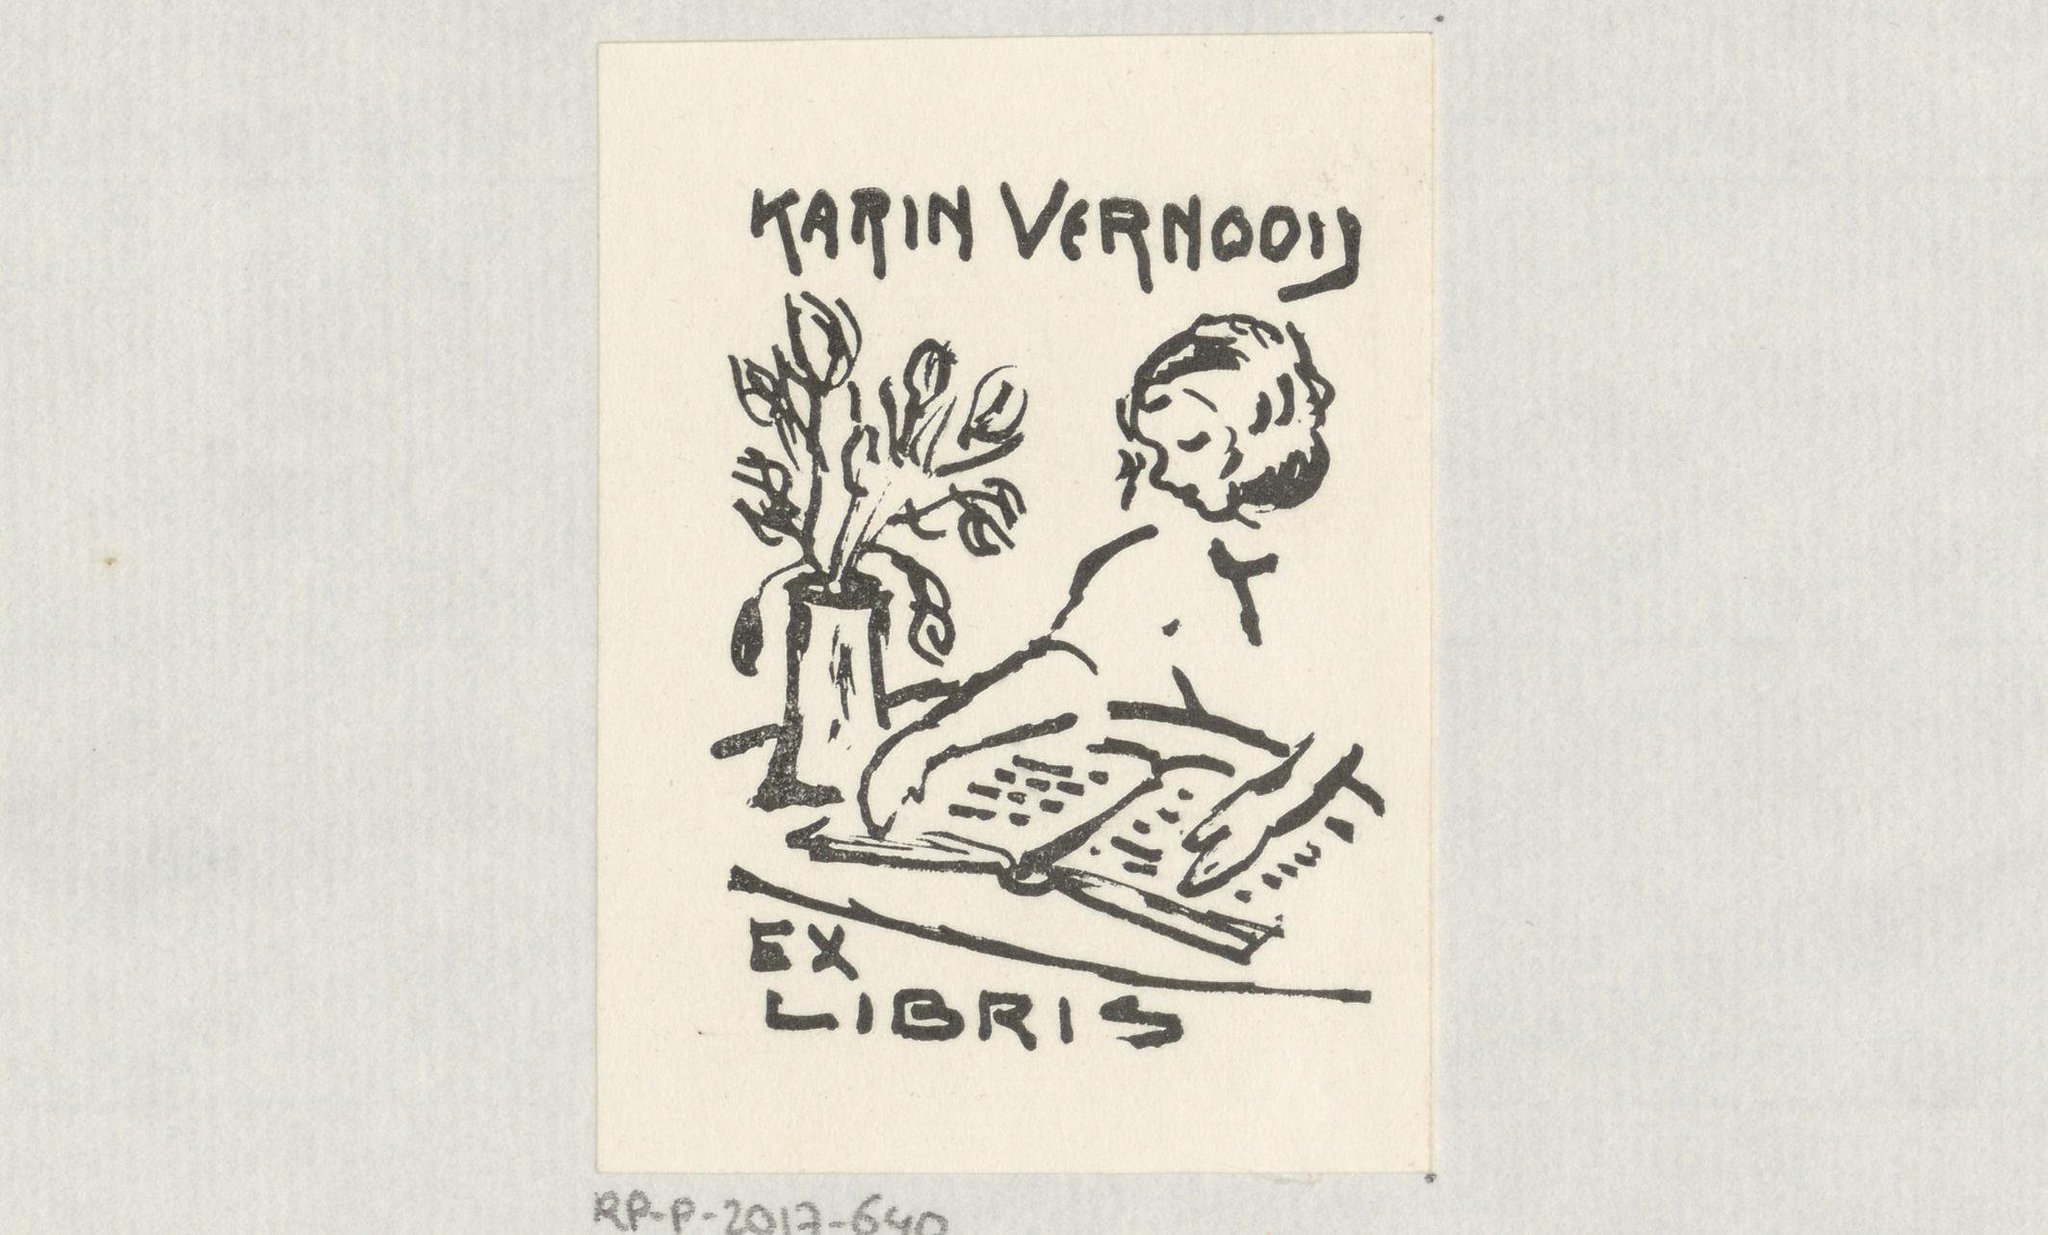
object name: bookplate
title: Ex libris van Karin Vernooij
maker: c. bregman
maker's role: print maker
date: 1900-1999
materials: paper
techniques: printing block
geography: netherlands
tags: adolescent, young woman, maiden, reading, flowers in a vase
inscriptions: inscription: ‘C. Bregman’